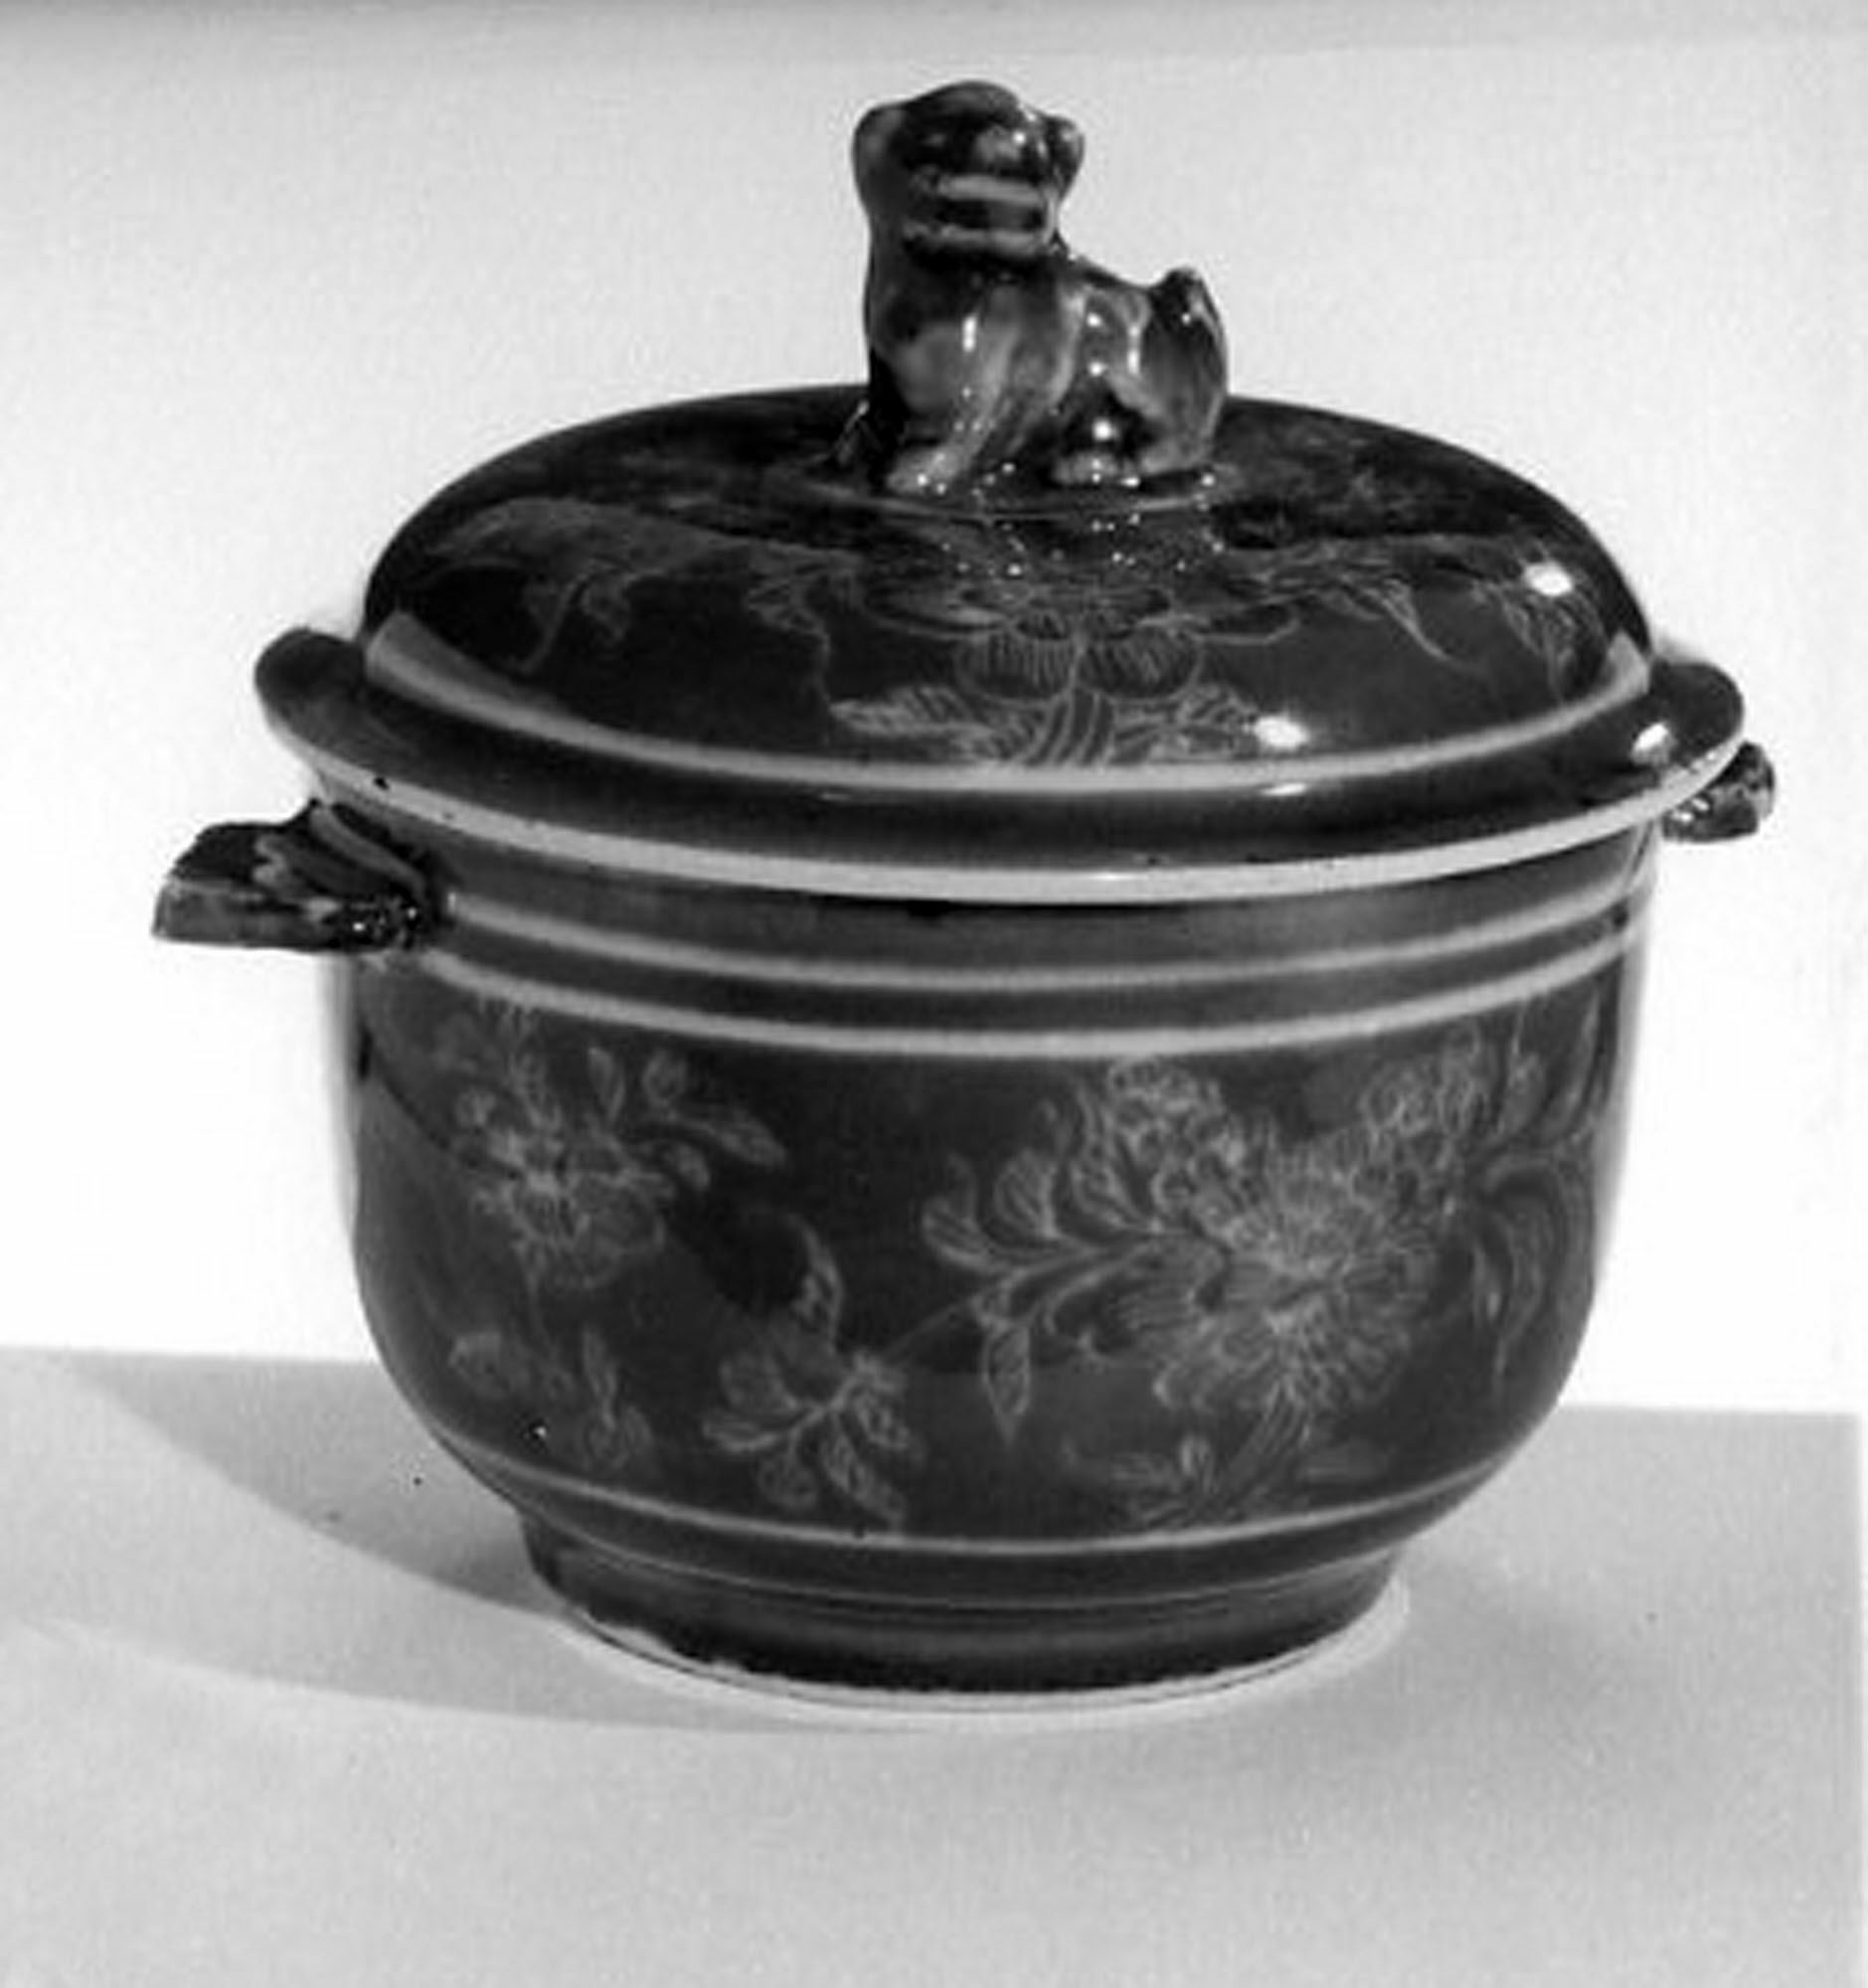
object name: cup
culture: chinese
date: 1667-1733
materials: porcelain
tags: animals,flowers